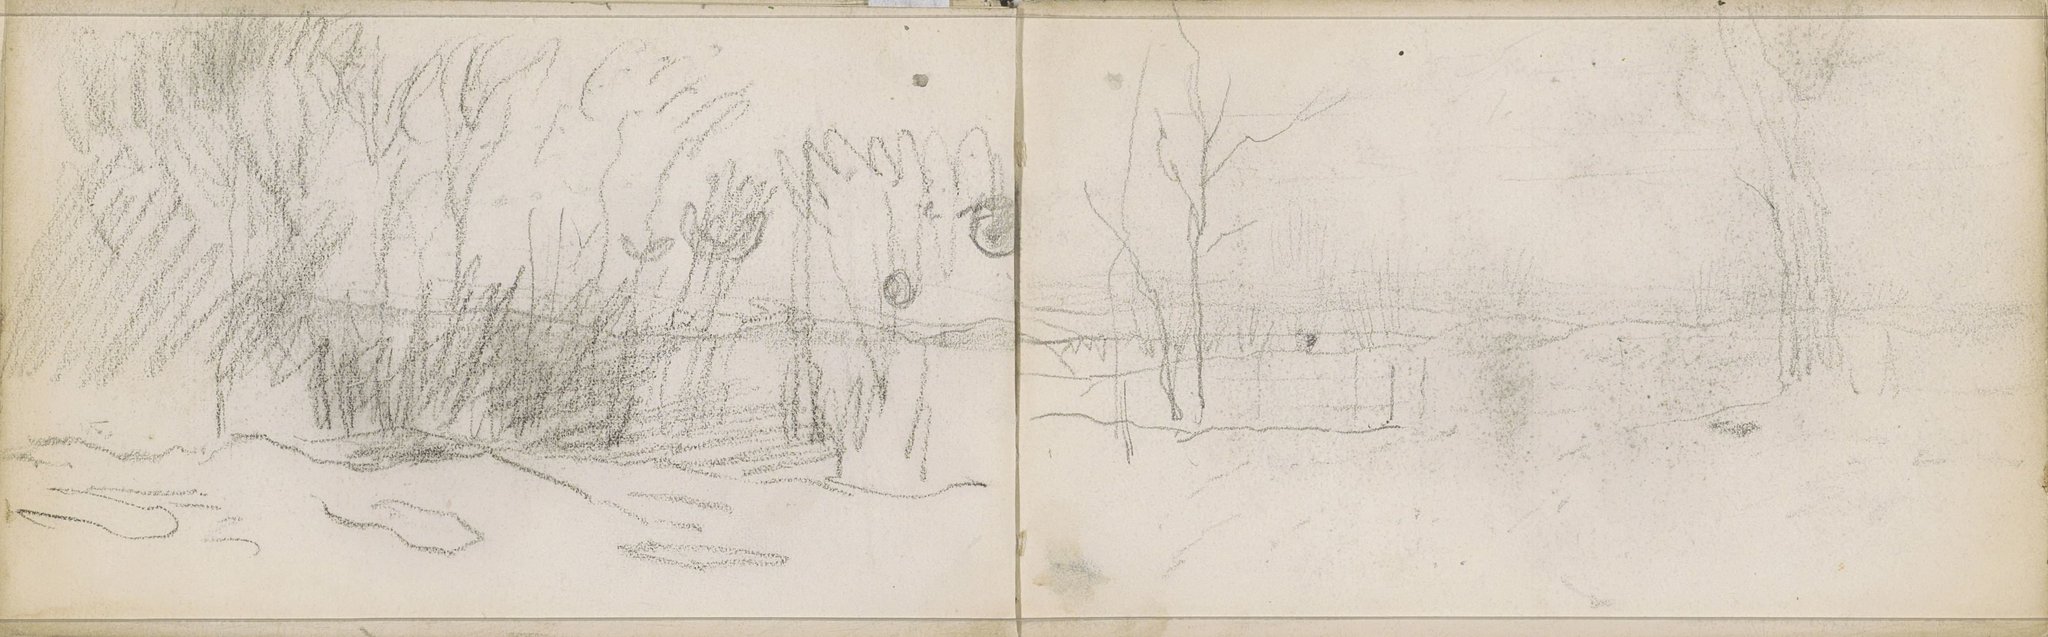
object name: sketchbook leaf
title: Landschap met bomen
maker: anton mauve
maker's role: draughtsman, painter, print maker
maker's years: 1838-1888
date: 1848-1888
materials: chalk, paper, pencil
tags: landscapes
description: Blad 5 verso en 6 recto uit een schetsboek met 44 bladen.